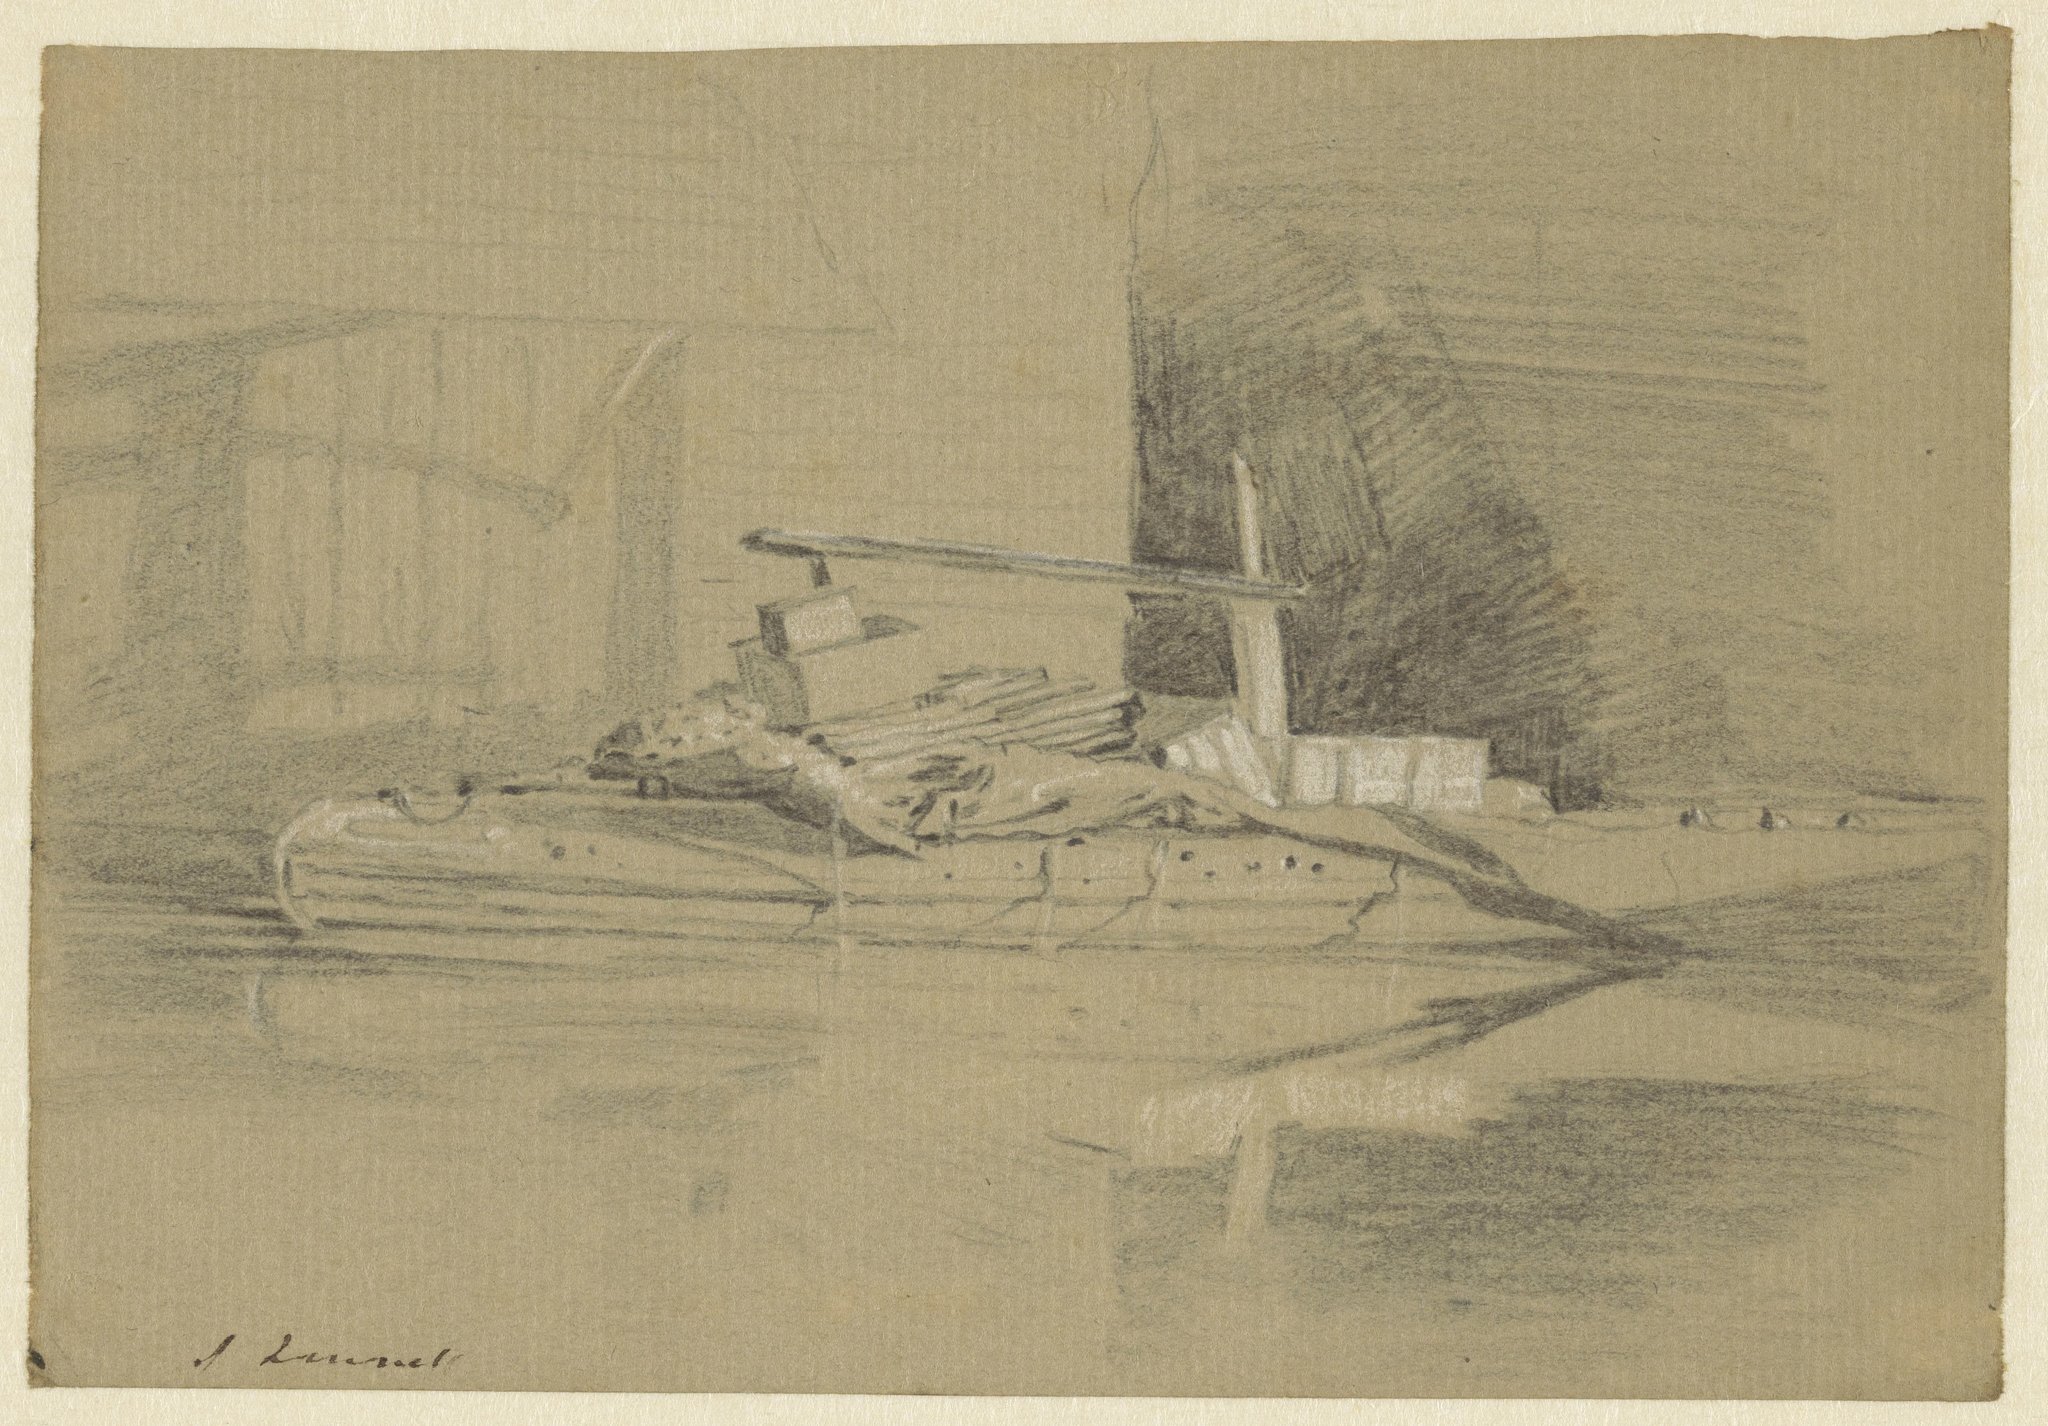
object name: drawing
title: Kademuur bij een loods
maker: john linnell (ii)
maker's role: draughtsman, print maker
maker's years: 1792-1882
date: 1806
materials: chalk, paper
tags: pier, quay, wharf